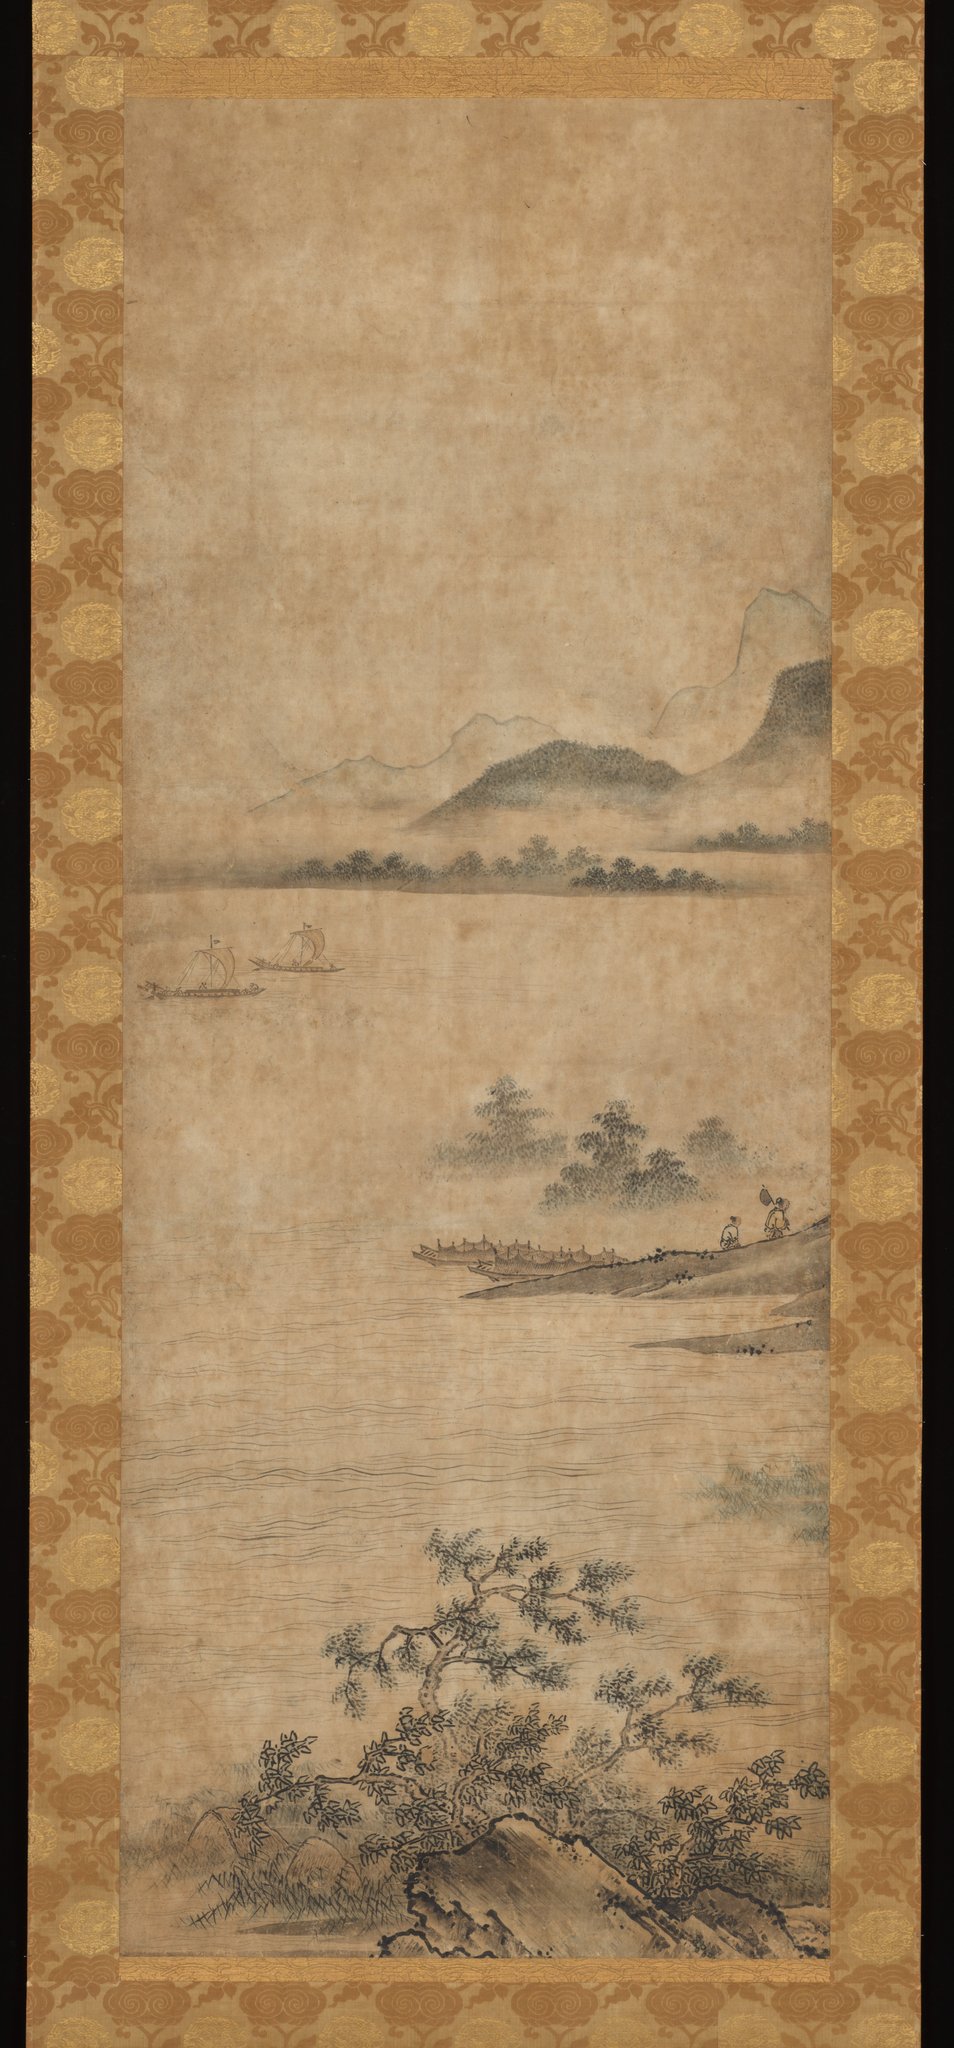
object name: hanging scroll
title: Eight Views of the Xiao and Xiang Rivers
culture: japanese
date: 1501-1600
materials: ink, paper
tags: mountains,landscapes,boats